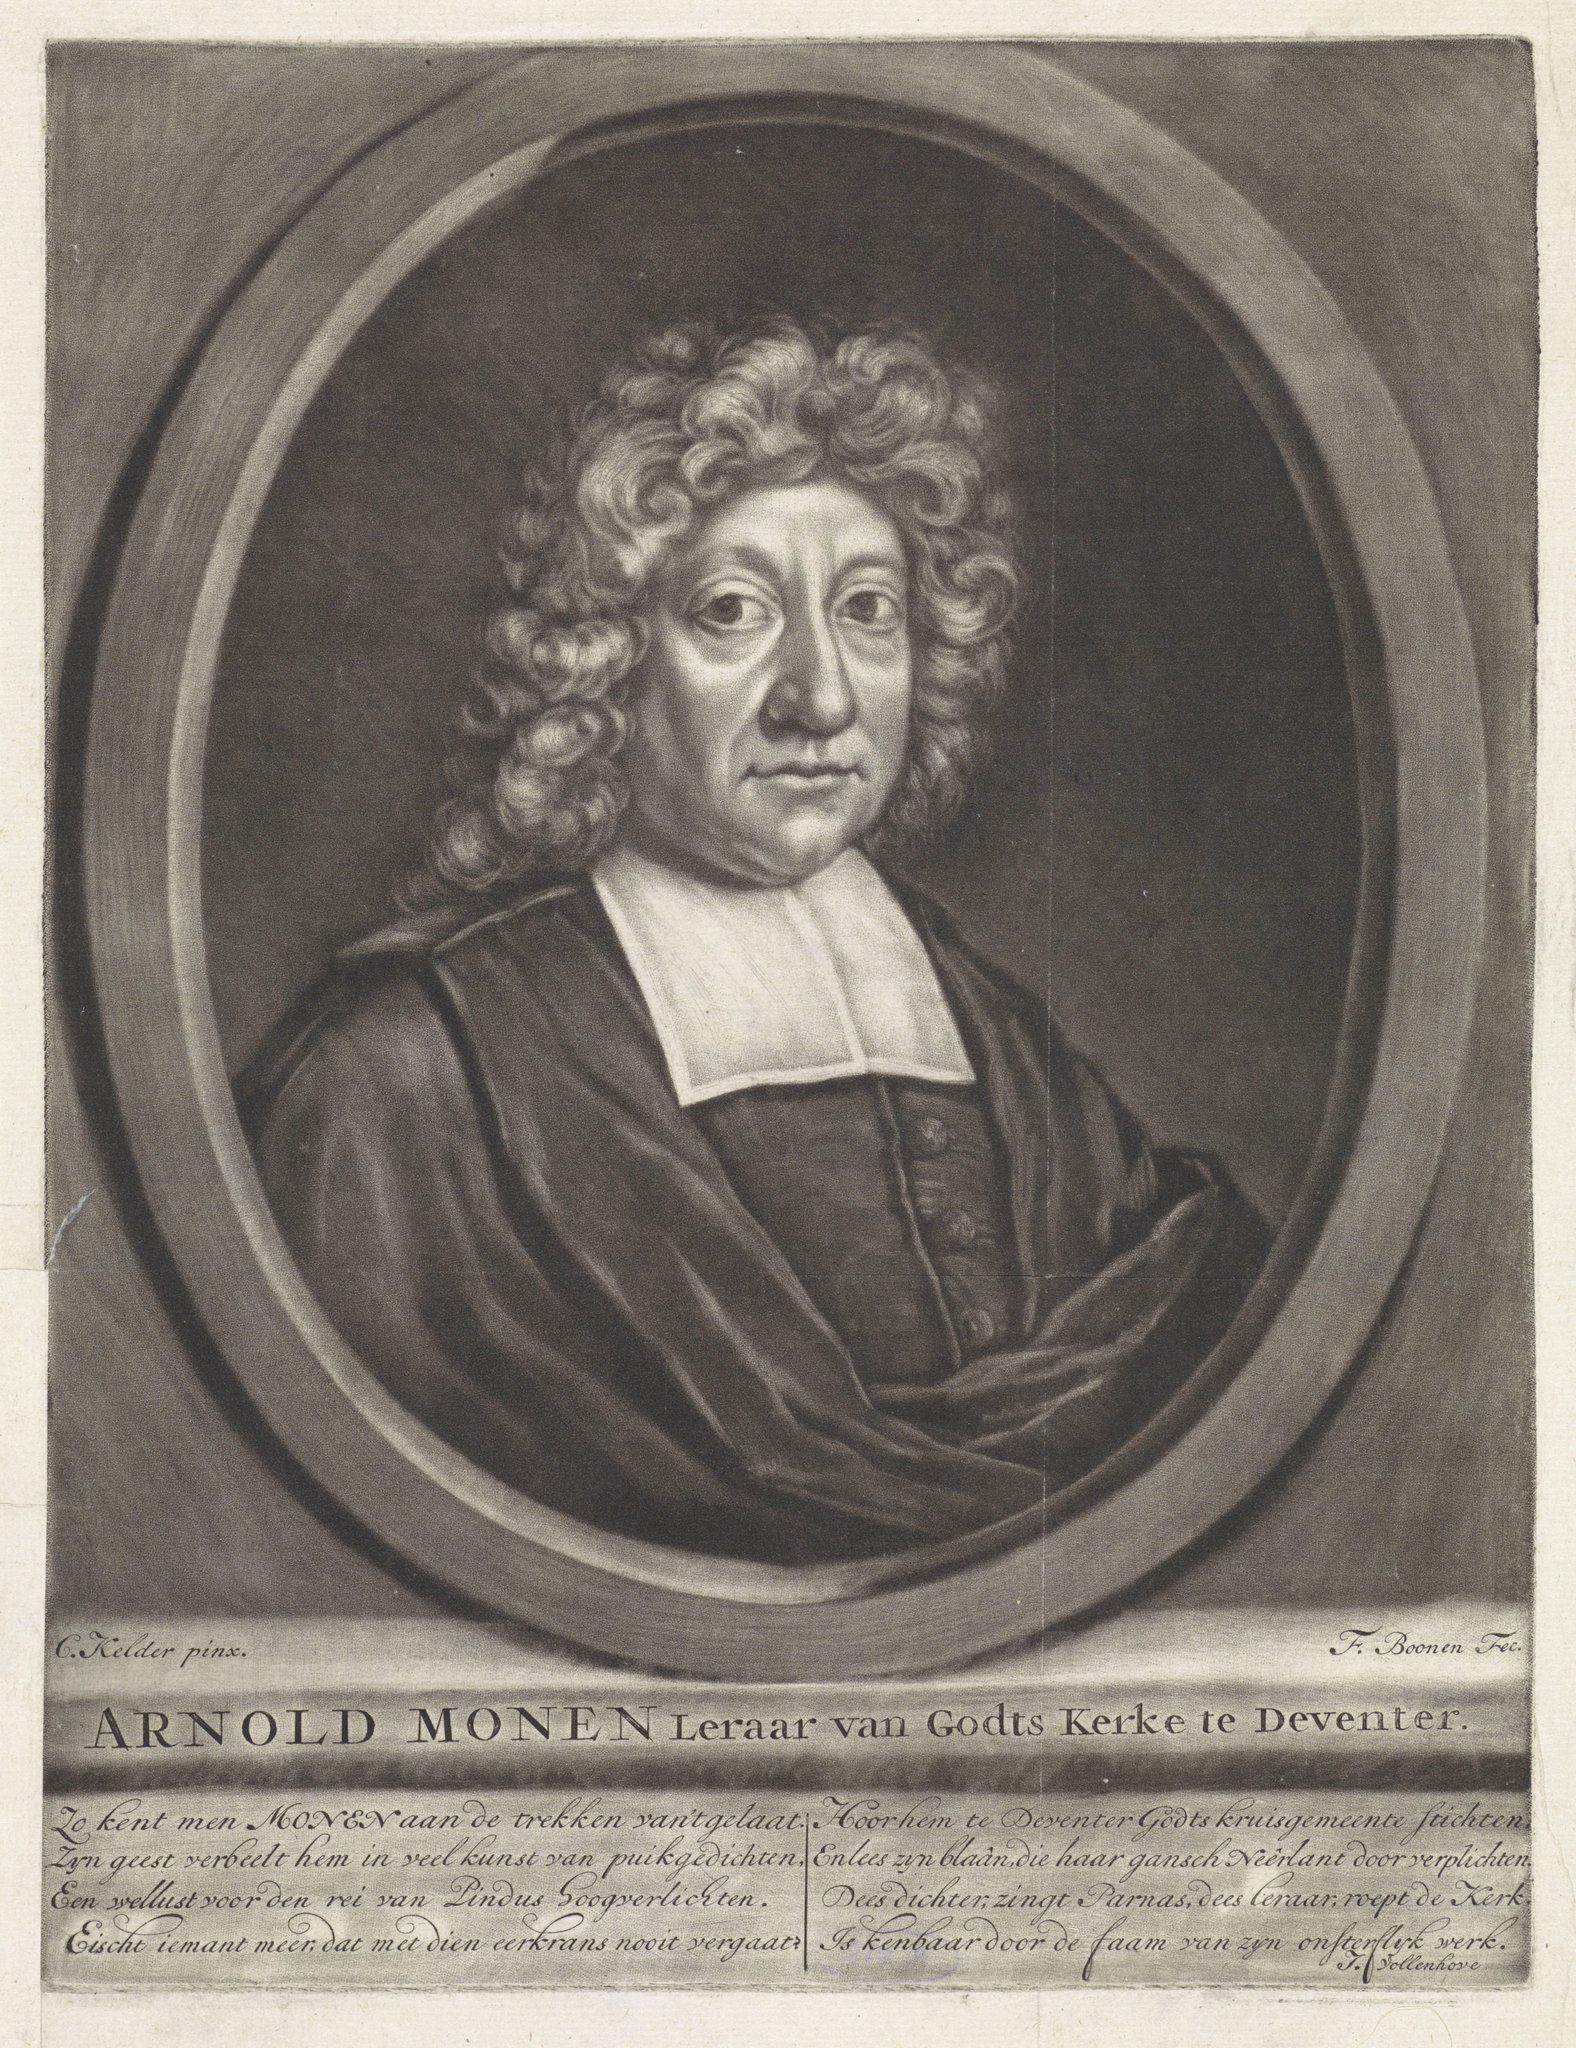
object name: print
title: Portret van Arnold Moonen (variant A)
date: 1708-1800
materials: paper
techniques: engraving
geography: middelburg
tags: deventer, arnold moonen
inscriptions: collector's mark: Lugt 2228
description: Portret van de predikant, dichter en taalkundige Arnold Moonen. Onder het portret een lofdicht op zijn werk.